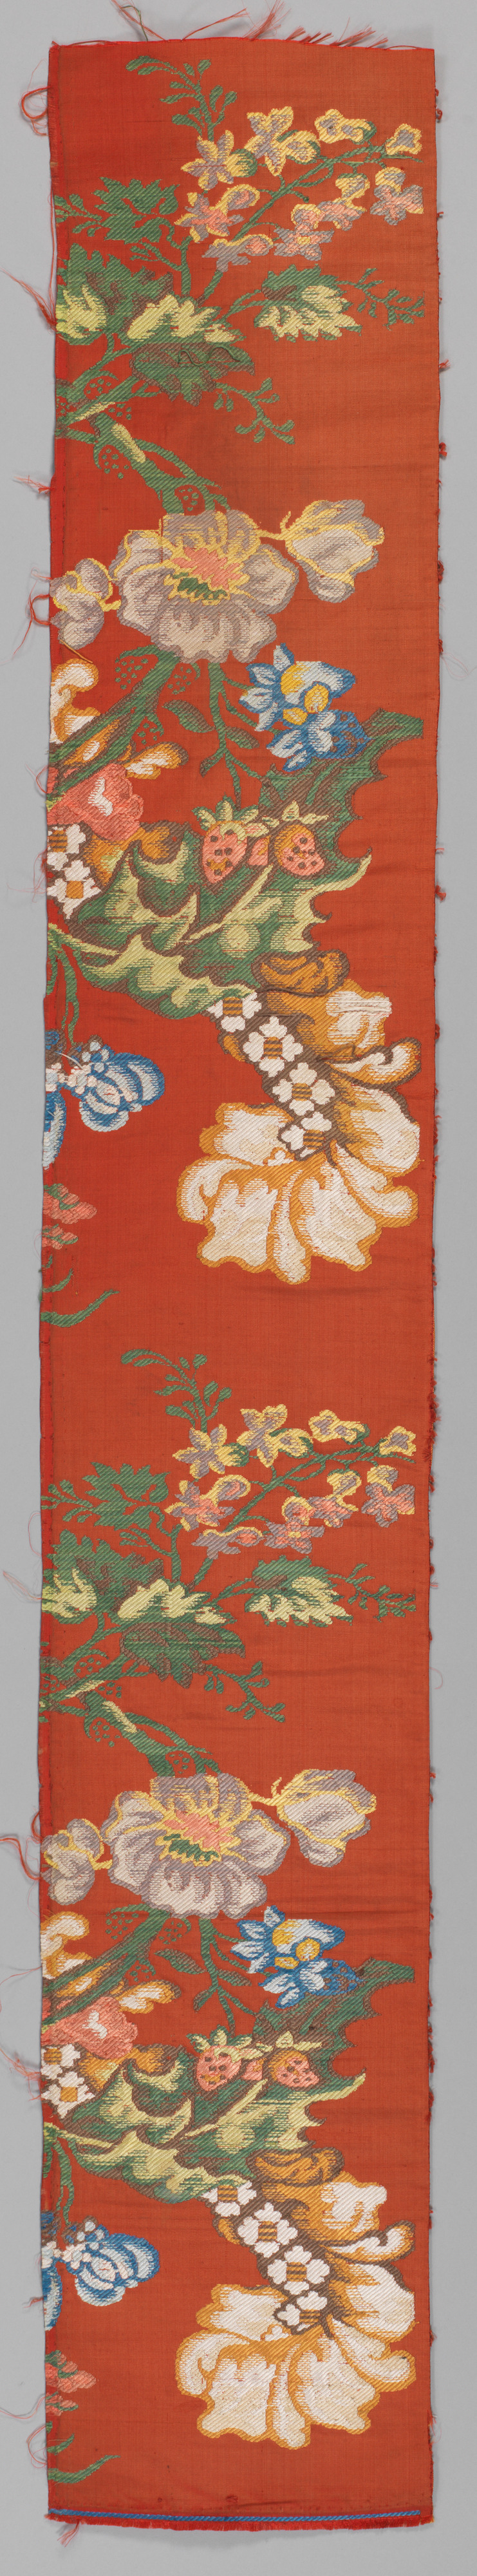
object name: fragment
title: Fragment of woven silk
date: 1734-1766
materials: silk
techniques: brocade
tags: flowers